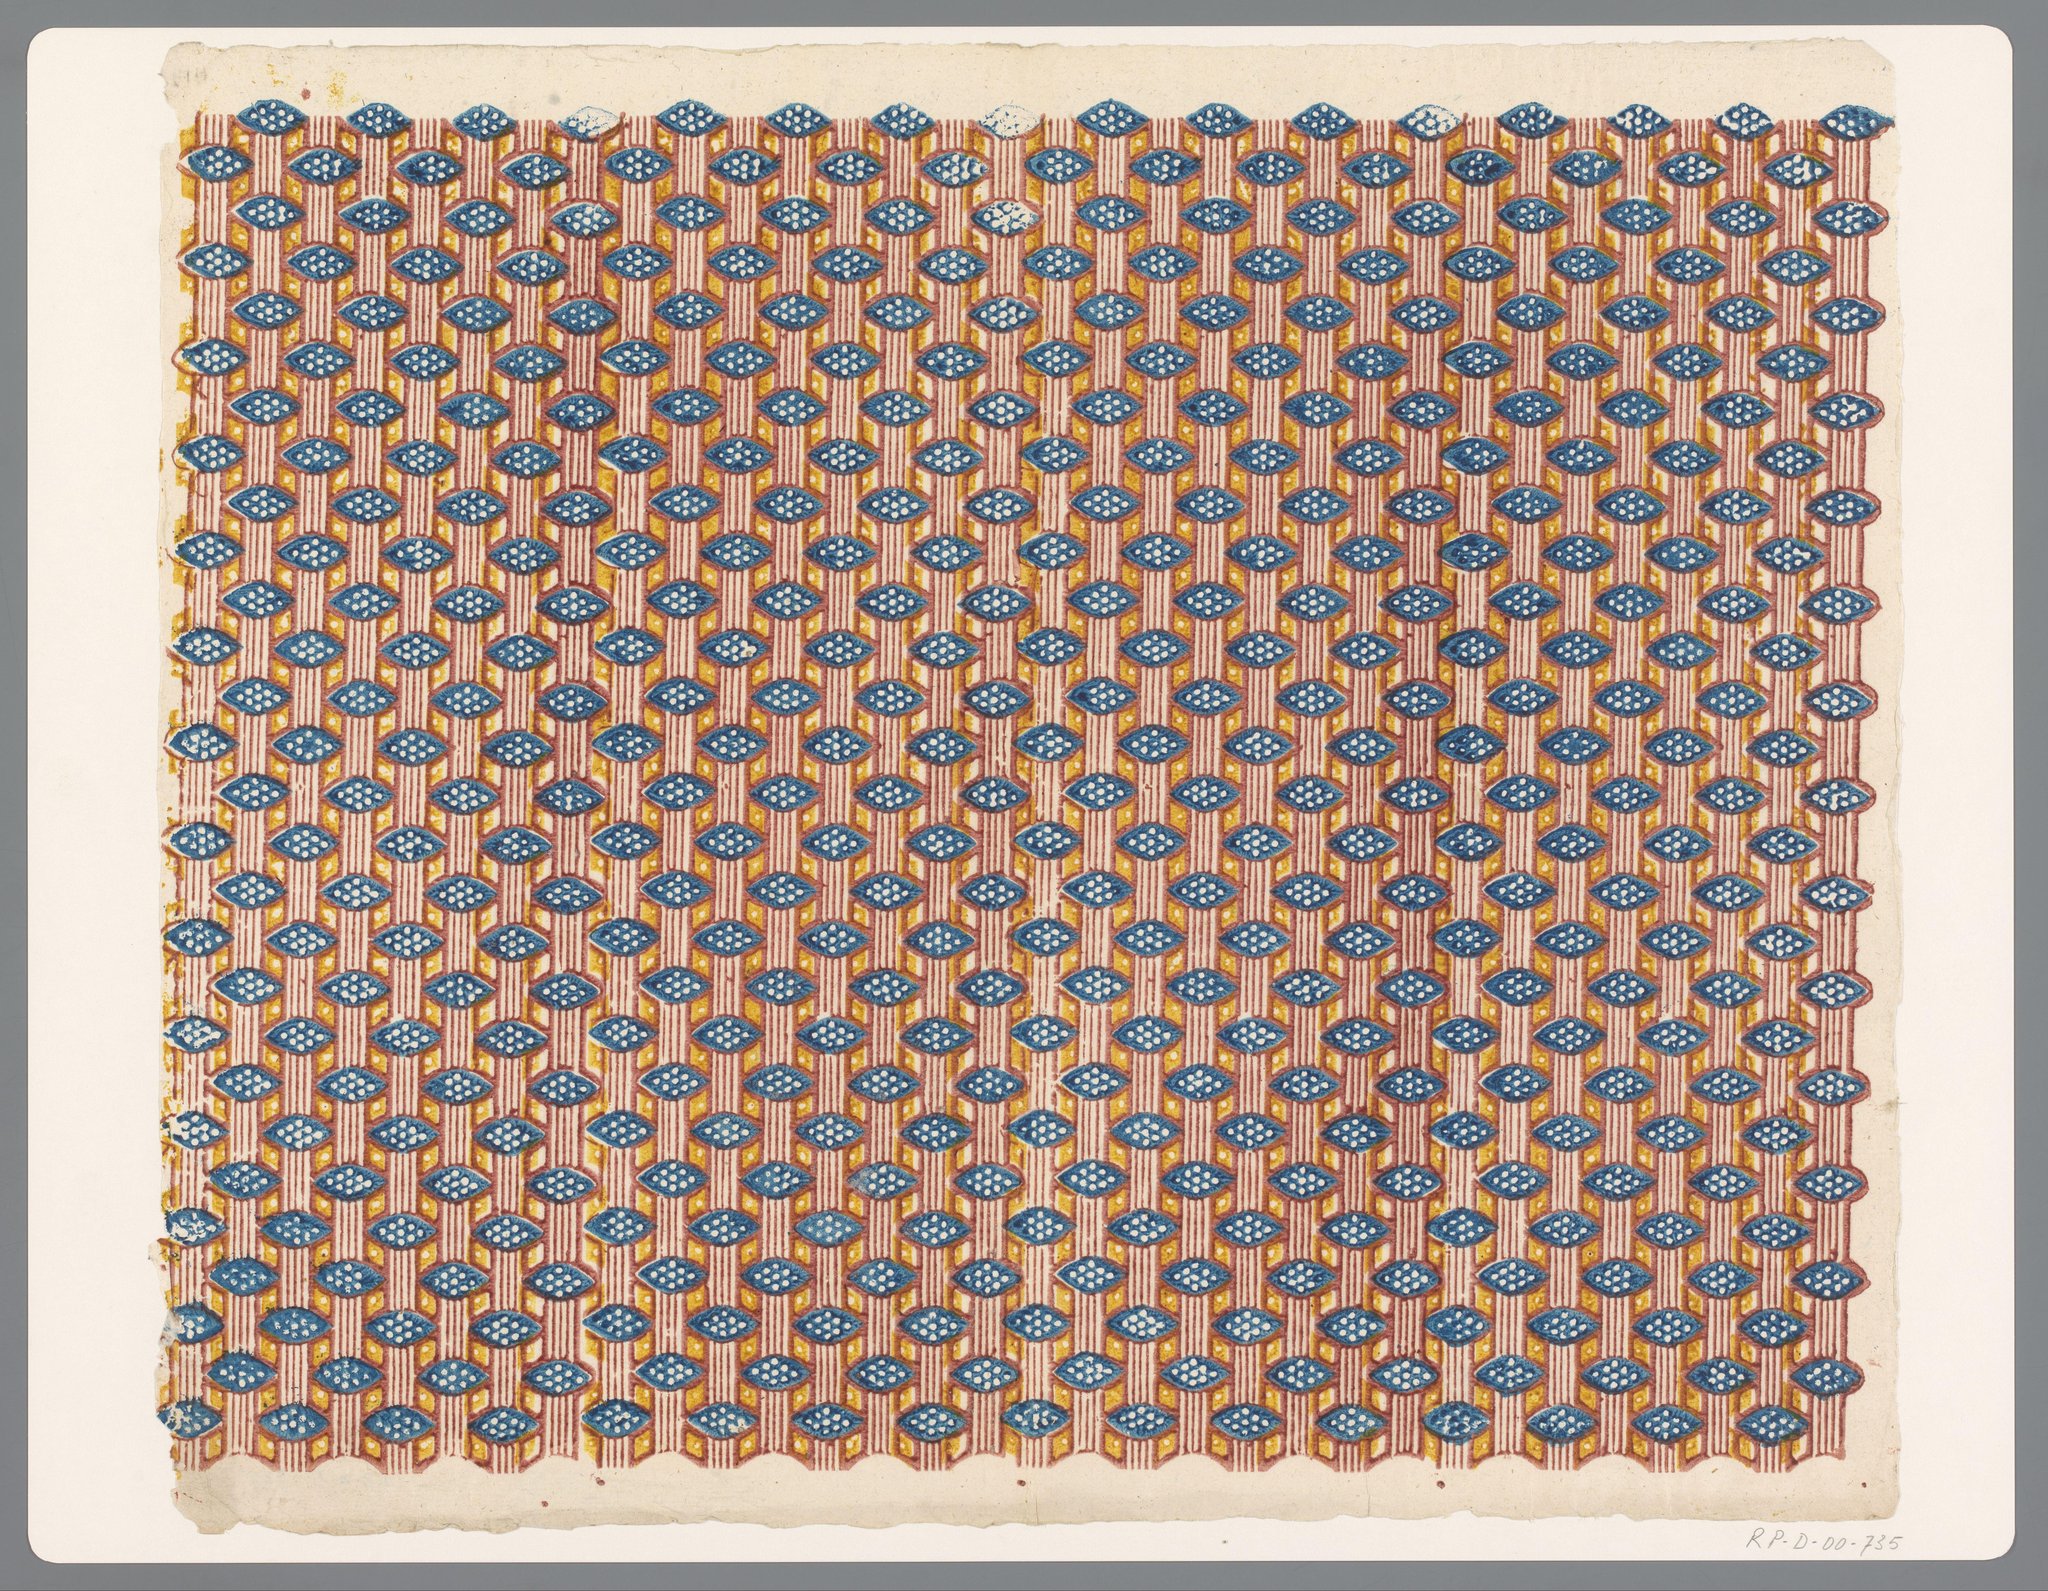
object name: printed paper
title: Blad met banenpatroon van motief met stippen op lijnen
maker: Anonymous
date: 1750-1900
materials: paper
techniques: printing block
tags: fantasy ornament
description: Blad met verticaal banenpatroon van een ruitachtig motief met uitgespaarde stippen op lijnen.